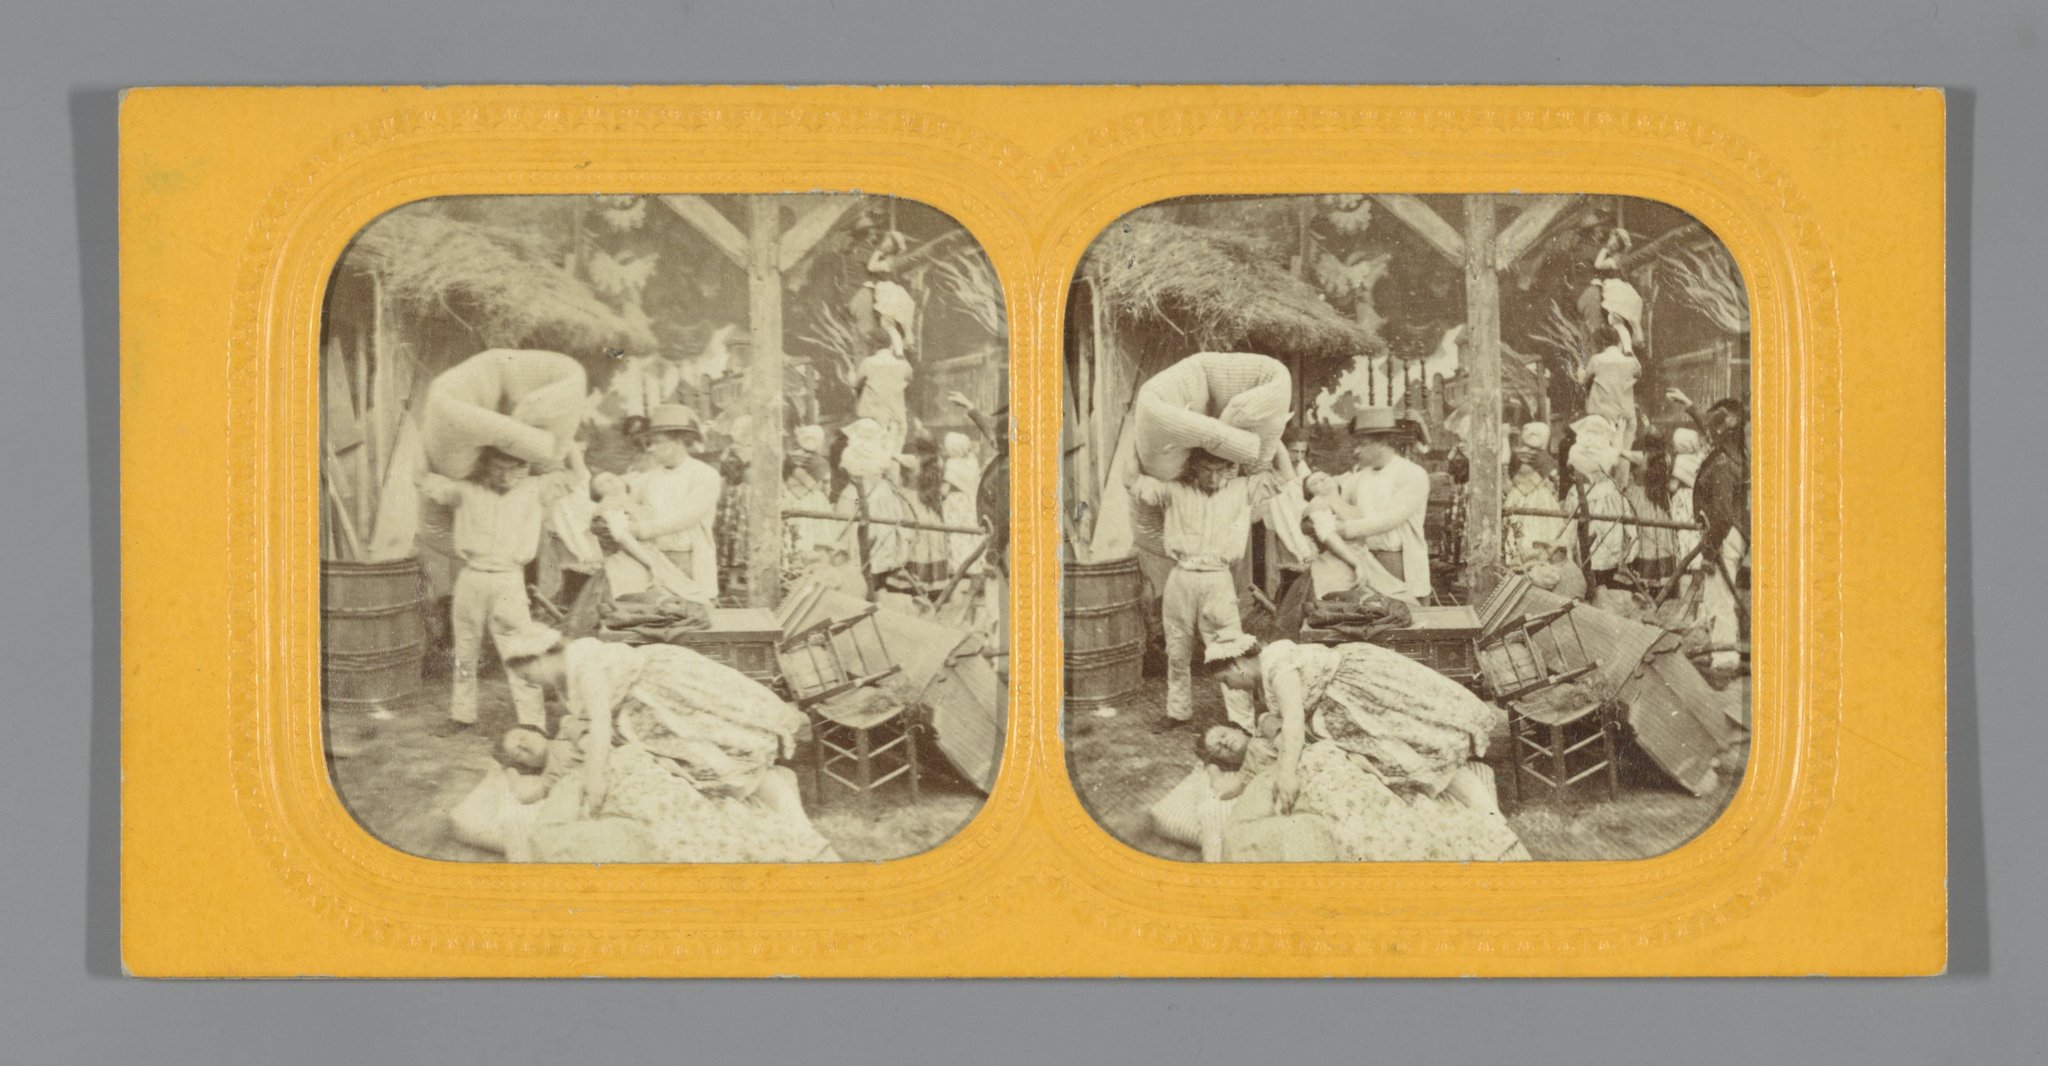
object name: tissue stereograph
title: Mensen en huisraad worden gered uit brandend huis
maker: Anonymous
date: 1855-1875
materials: cardboard, paper, photographic support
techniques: albumen print, cutting, hand coloring, perforating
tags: rescue from fire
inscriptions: inscription: ‘60 ct per (...)/ f6 per dozijn’